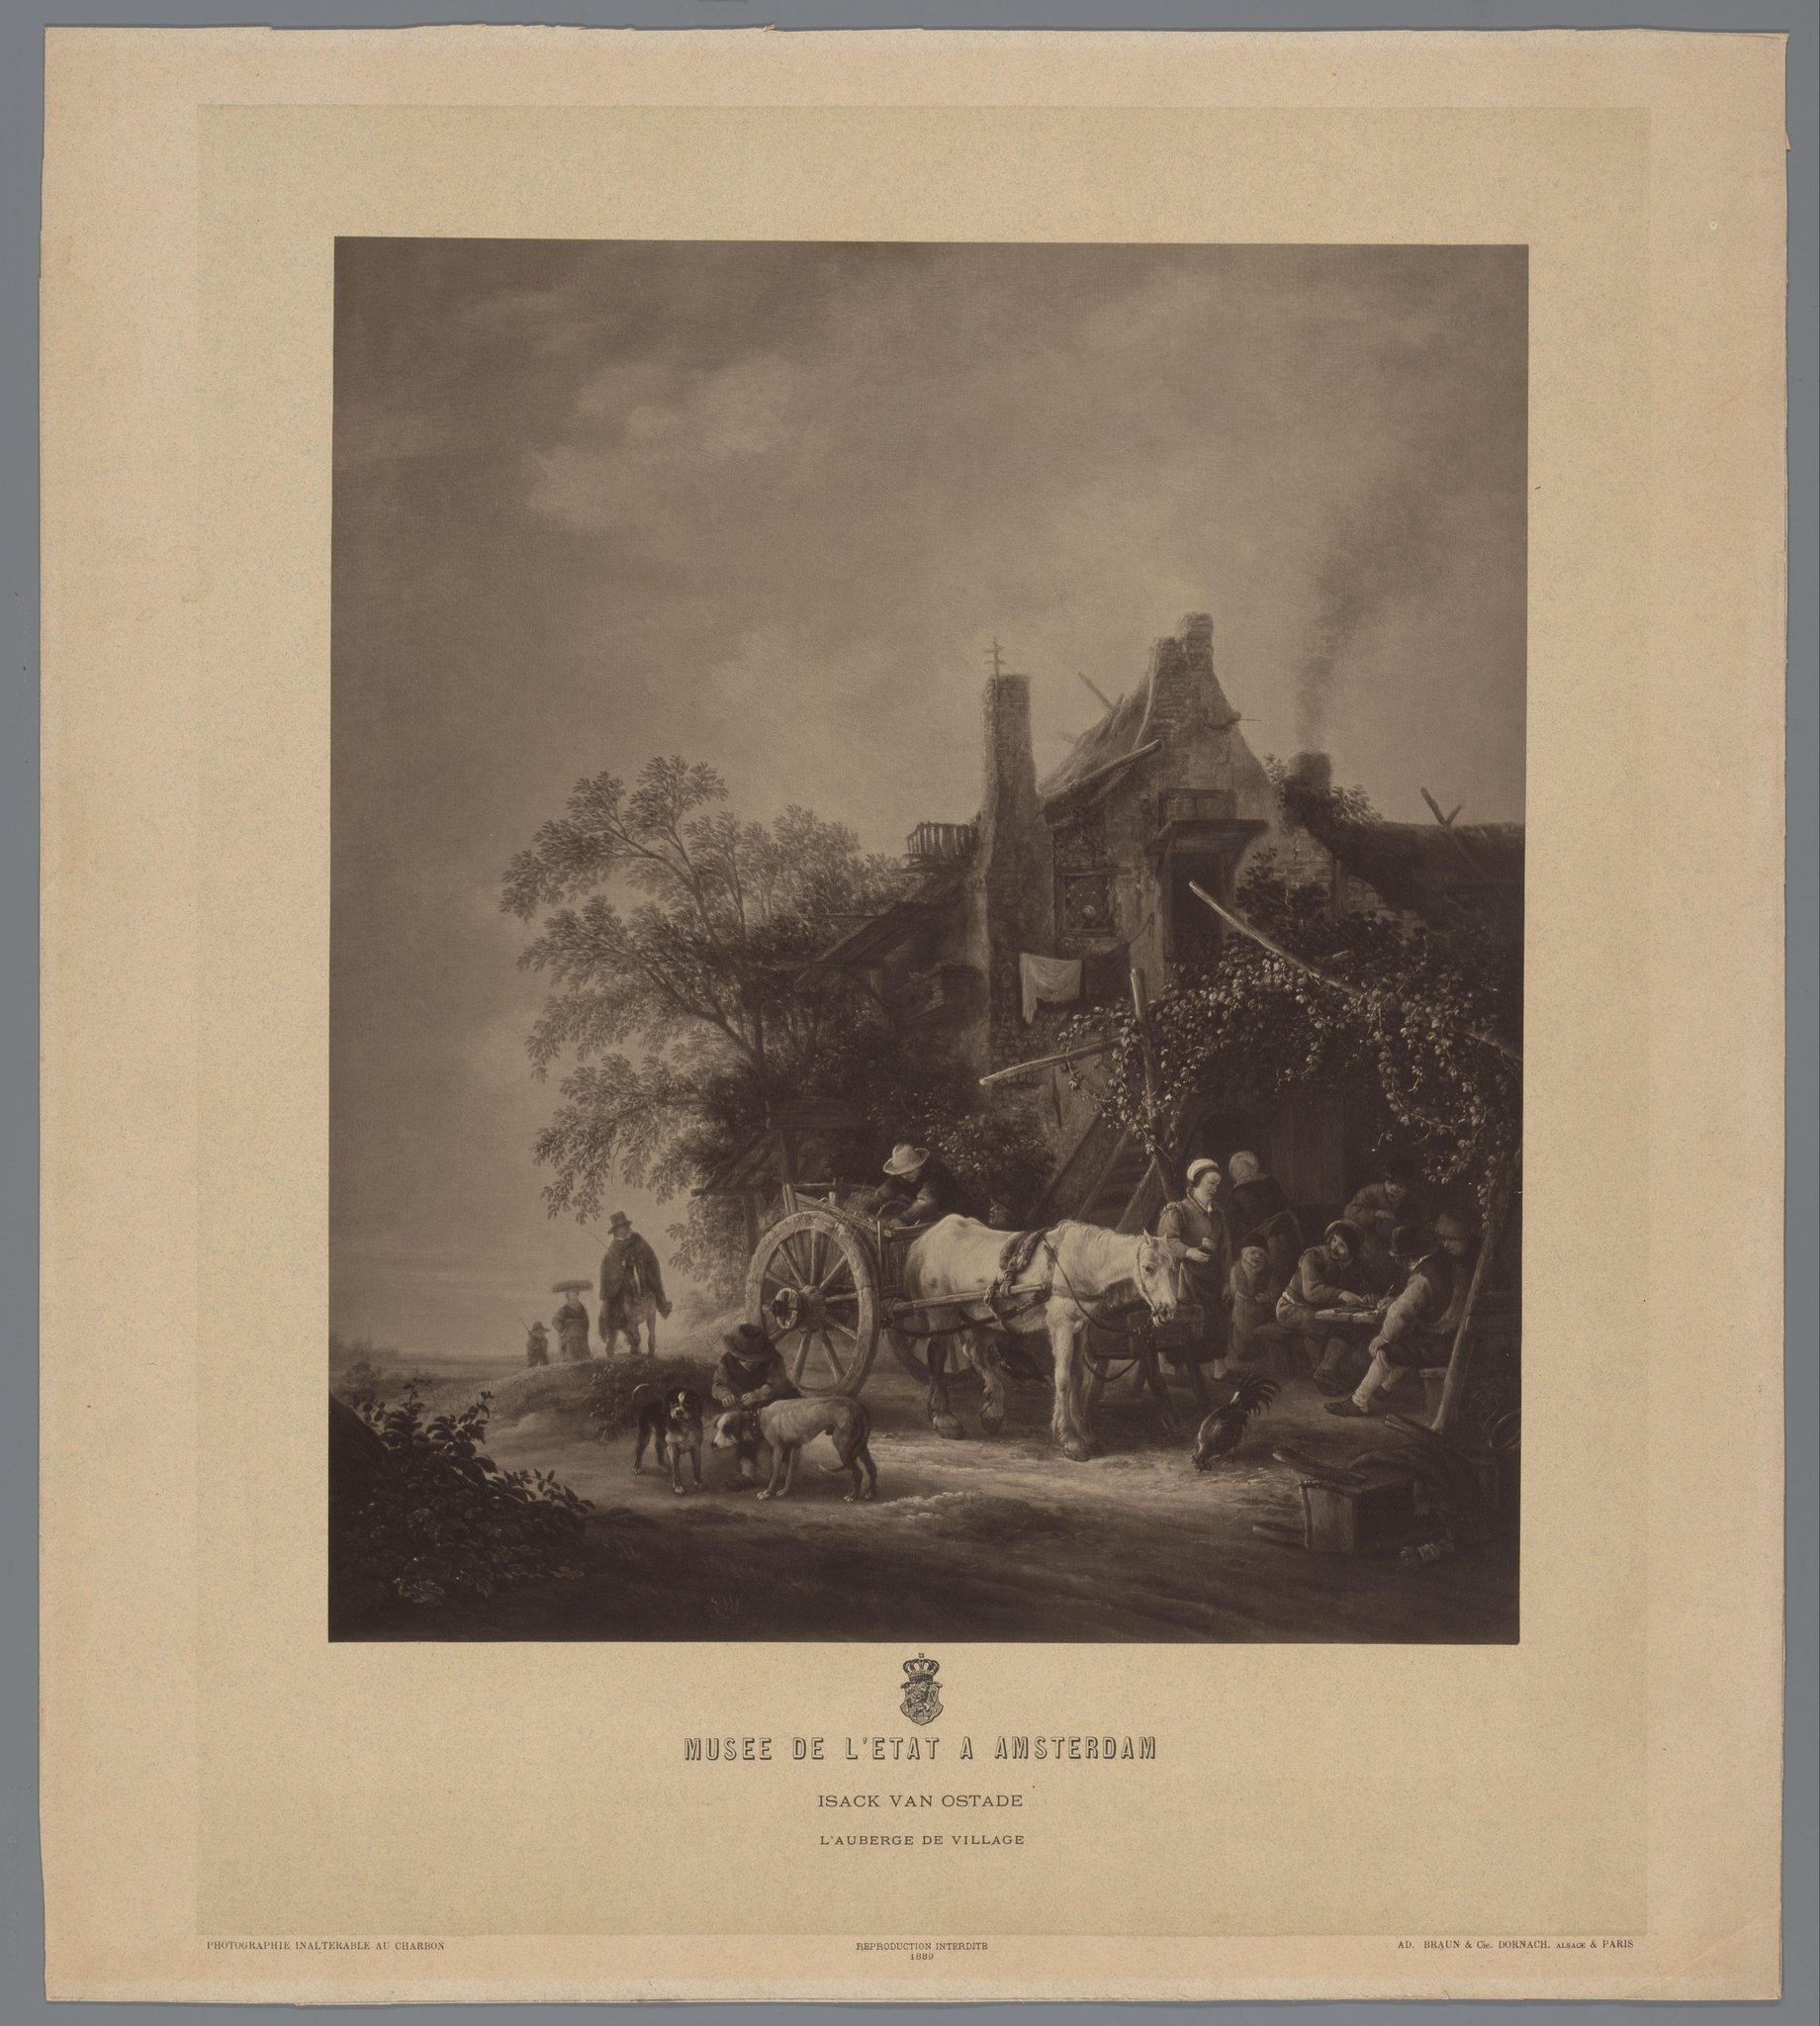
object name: photograph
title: Fotoreproductie van een schilderij van Isaack van Ostade, 'Boerenherberg met paard aan de trog' (coll. Rijksmuseum)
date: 1889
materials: cardboard, paper, photographic support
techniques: carbon print